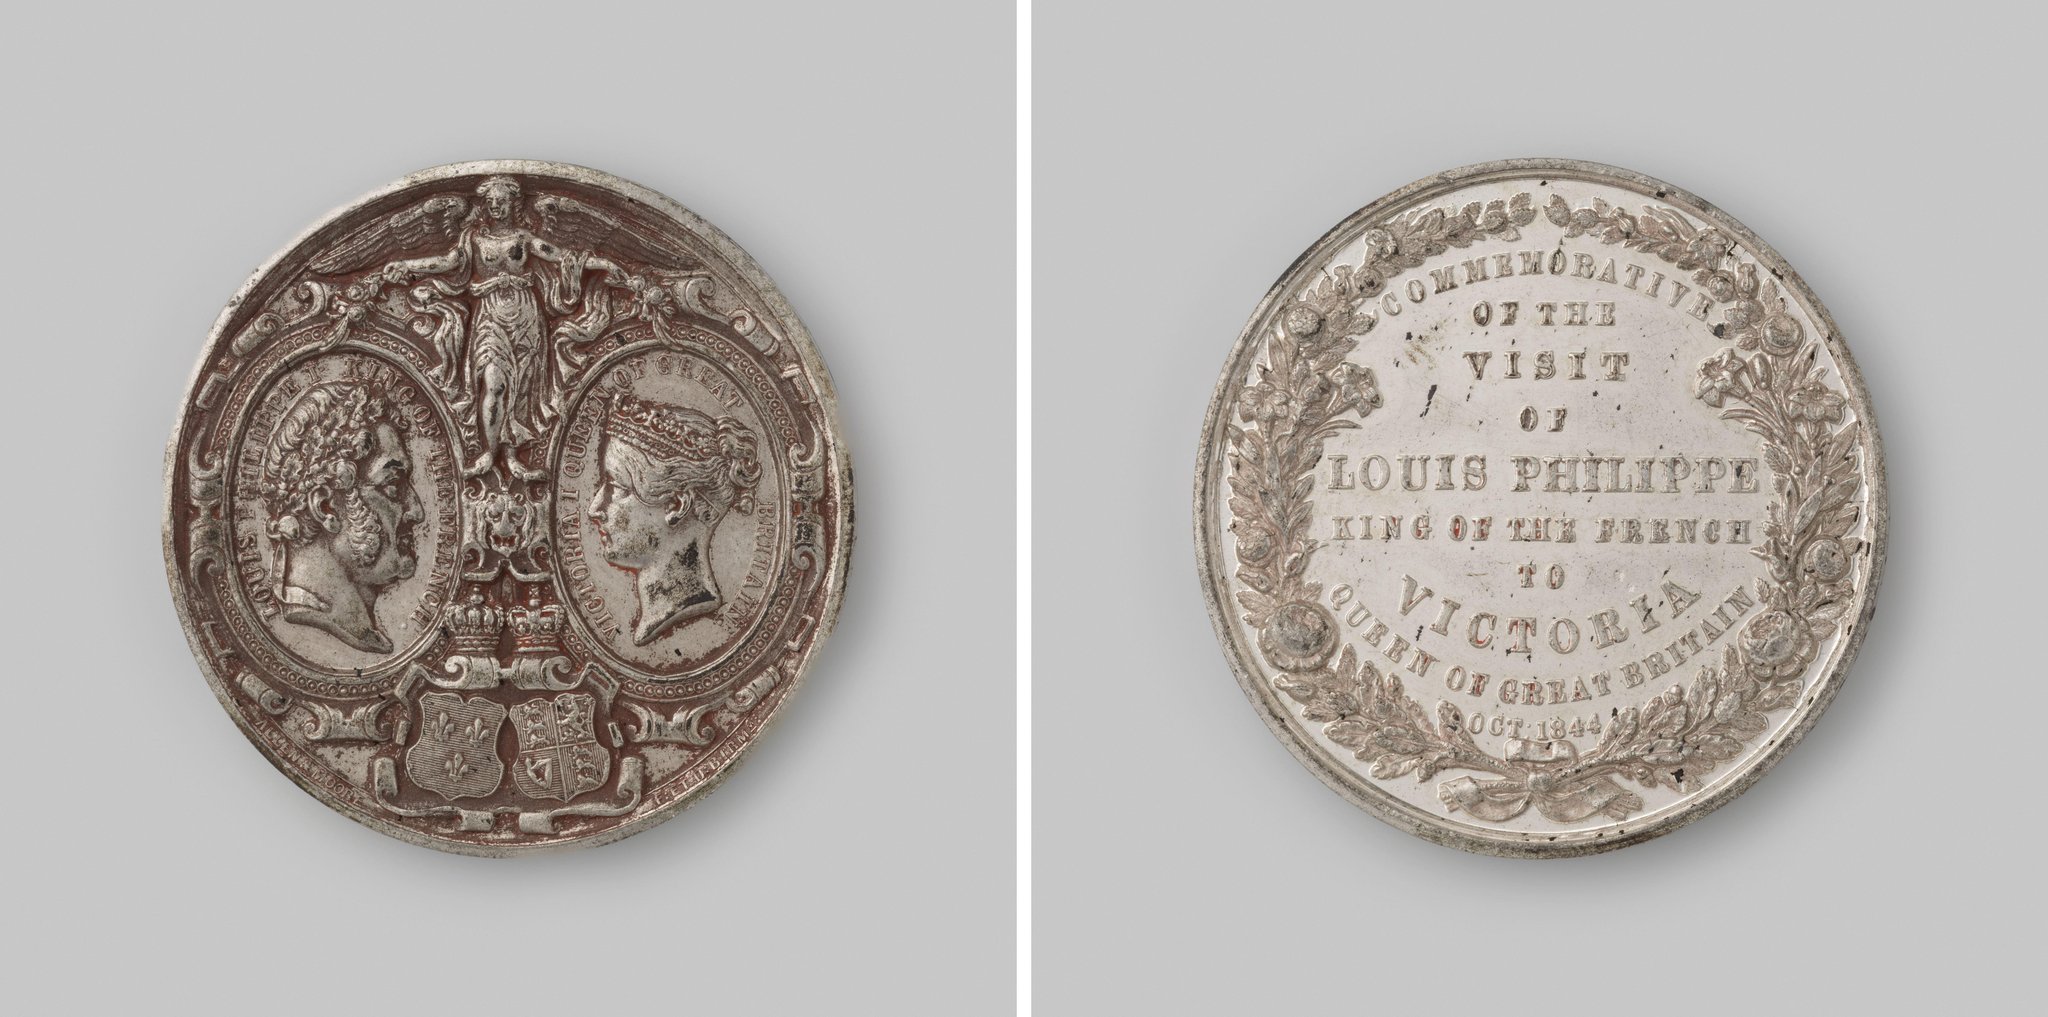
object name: history medal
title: Bezoek van Koning Louis Philippe van Frankrijk aan Engeland 1844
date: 1844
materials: tin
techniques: striking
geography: birmingham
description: Tinnen penning, op de voorzijde twee versierde ovalen medaillons met de portretten van Louis Philippe en Koningin Victoria gehouden door een engel, waaronder twee gekroonde wapenschilden, op de keerzijde tien regels tekst tussen samengestrikte bloementakken.